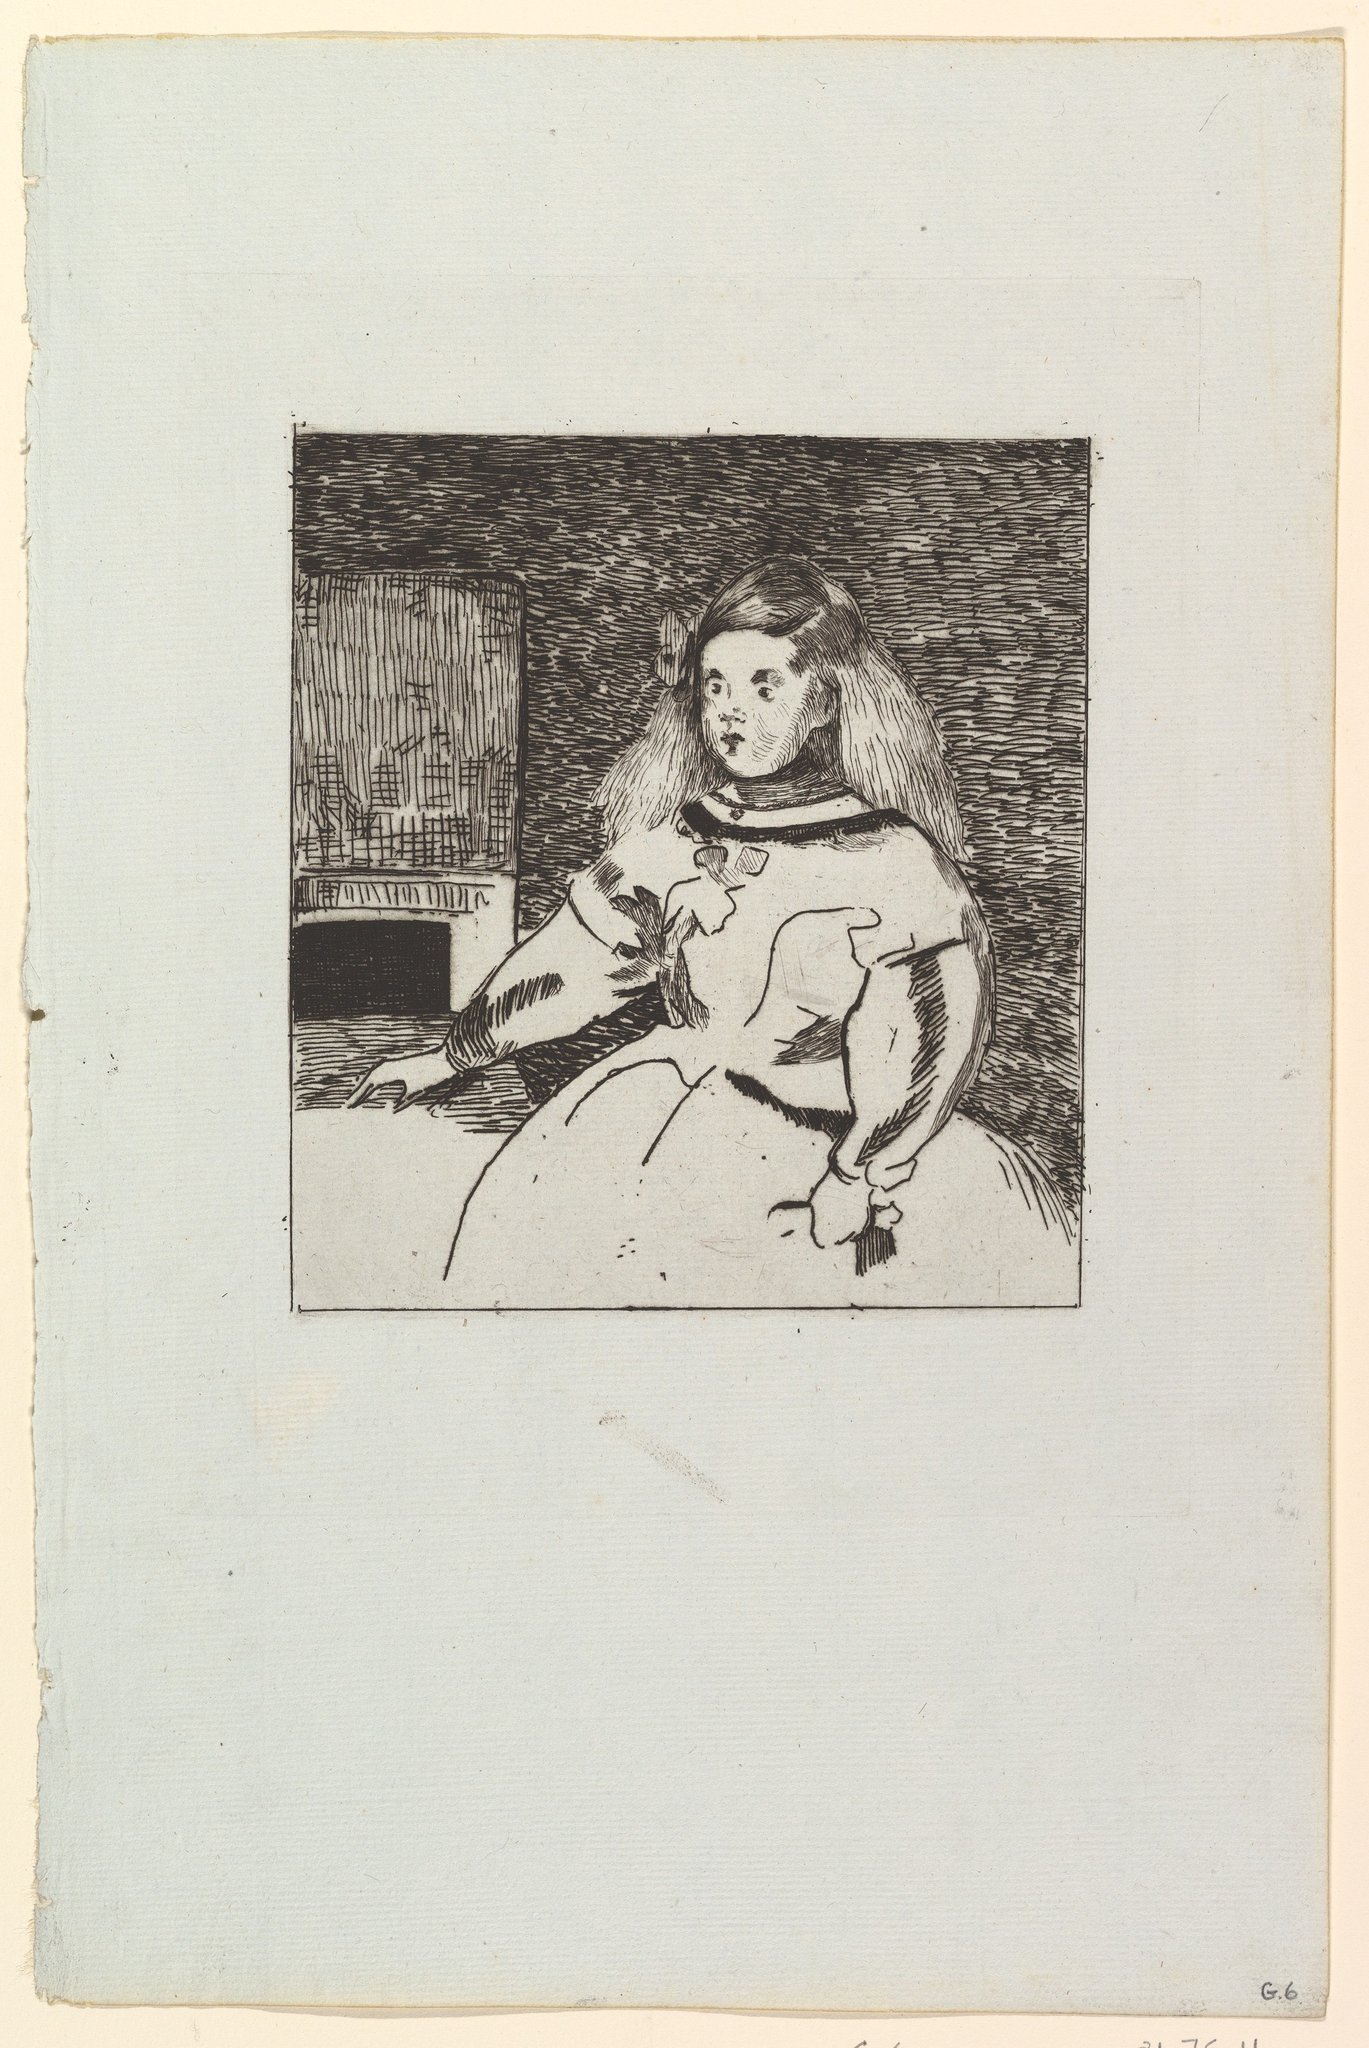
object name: print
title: The Infanta Marguerita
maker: édouard manet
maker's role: artist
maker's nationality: french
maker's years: 1832-1883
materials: paper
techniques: etching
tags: girls